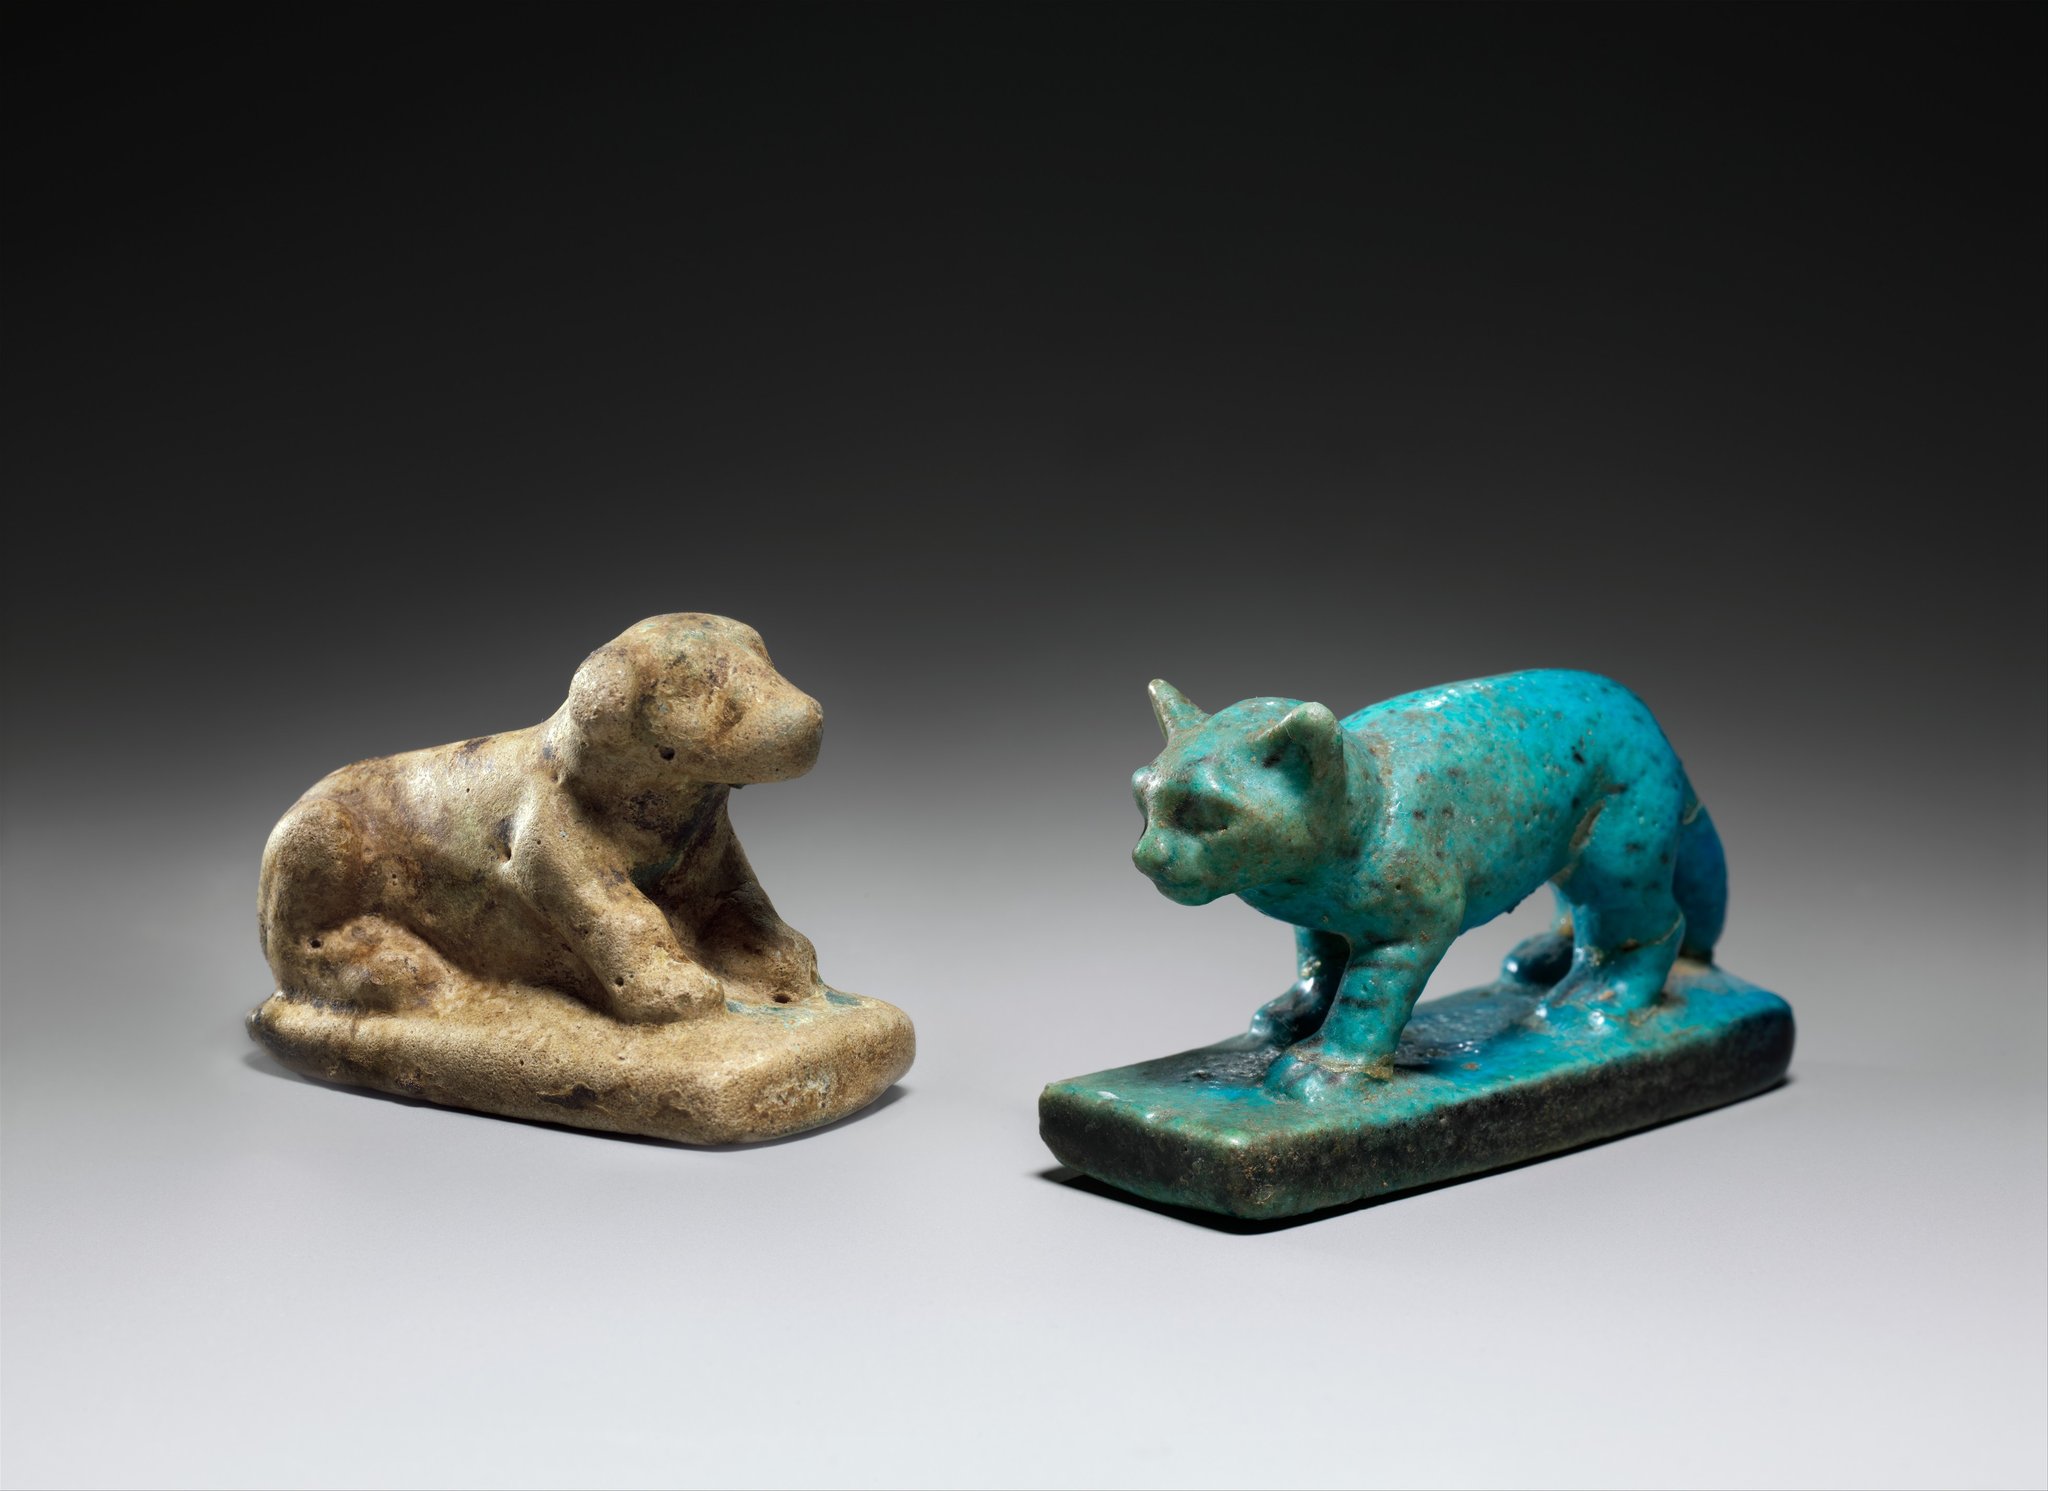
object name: figurine, cat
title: Cat figurine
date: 1981-1802 BCE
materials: faience, paint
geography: memphite region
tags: cats